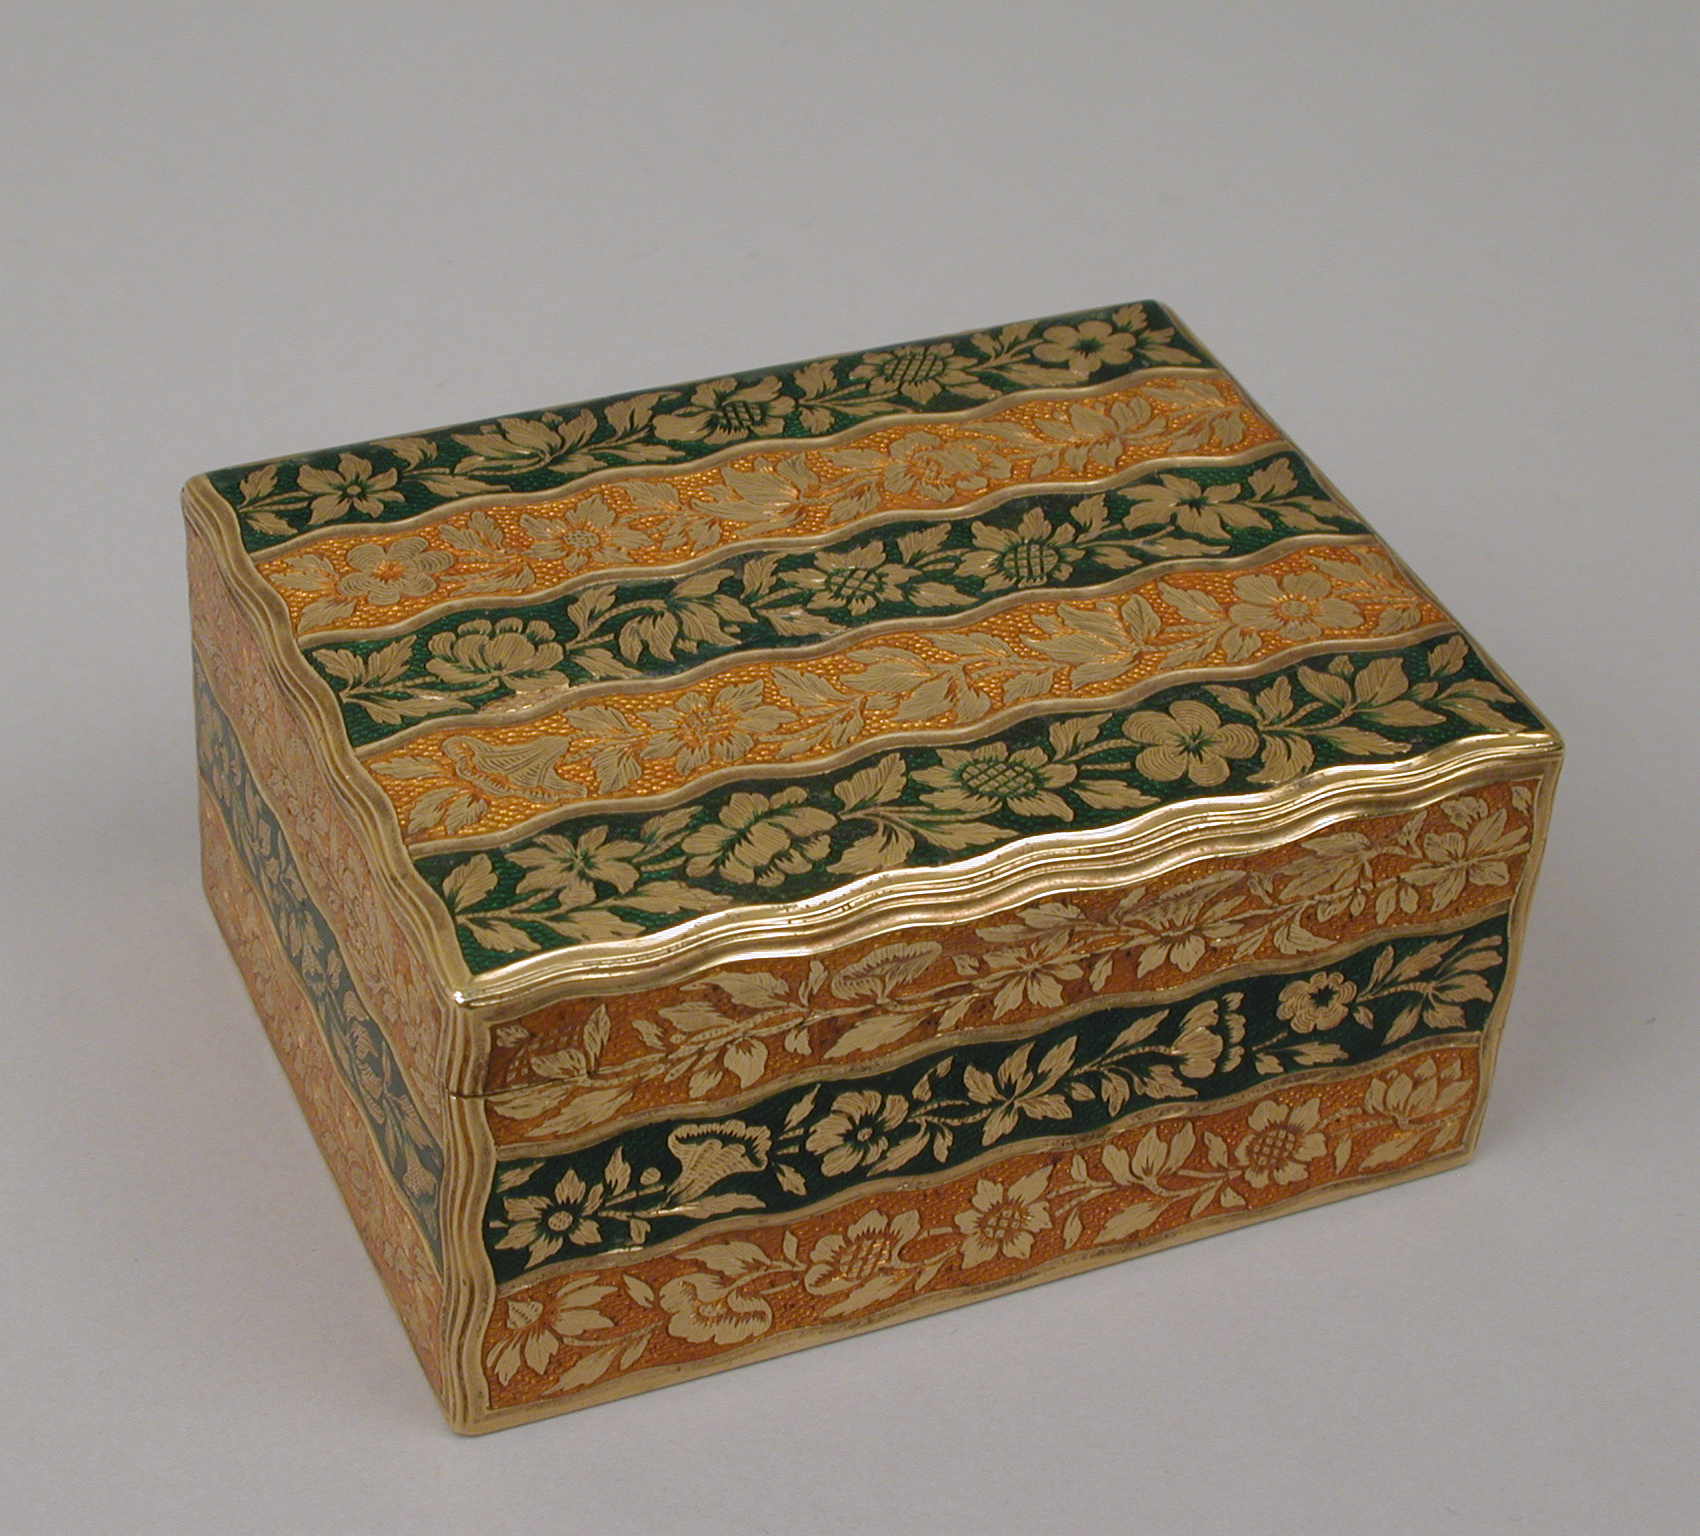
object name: snuffbox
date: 1748-1749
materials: enamel, gold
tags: flowers